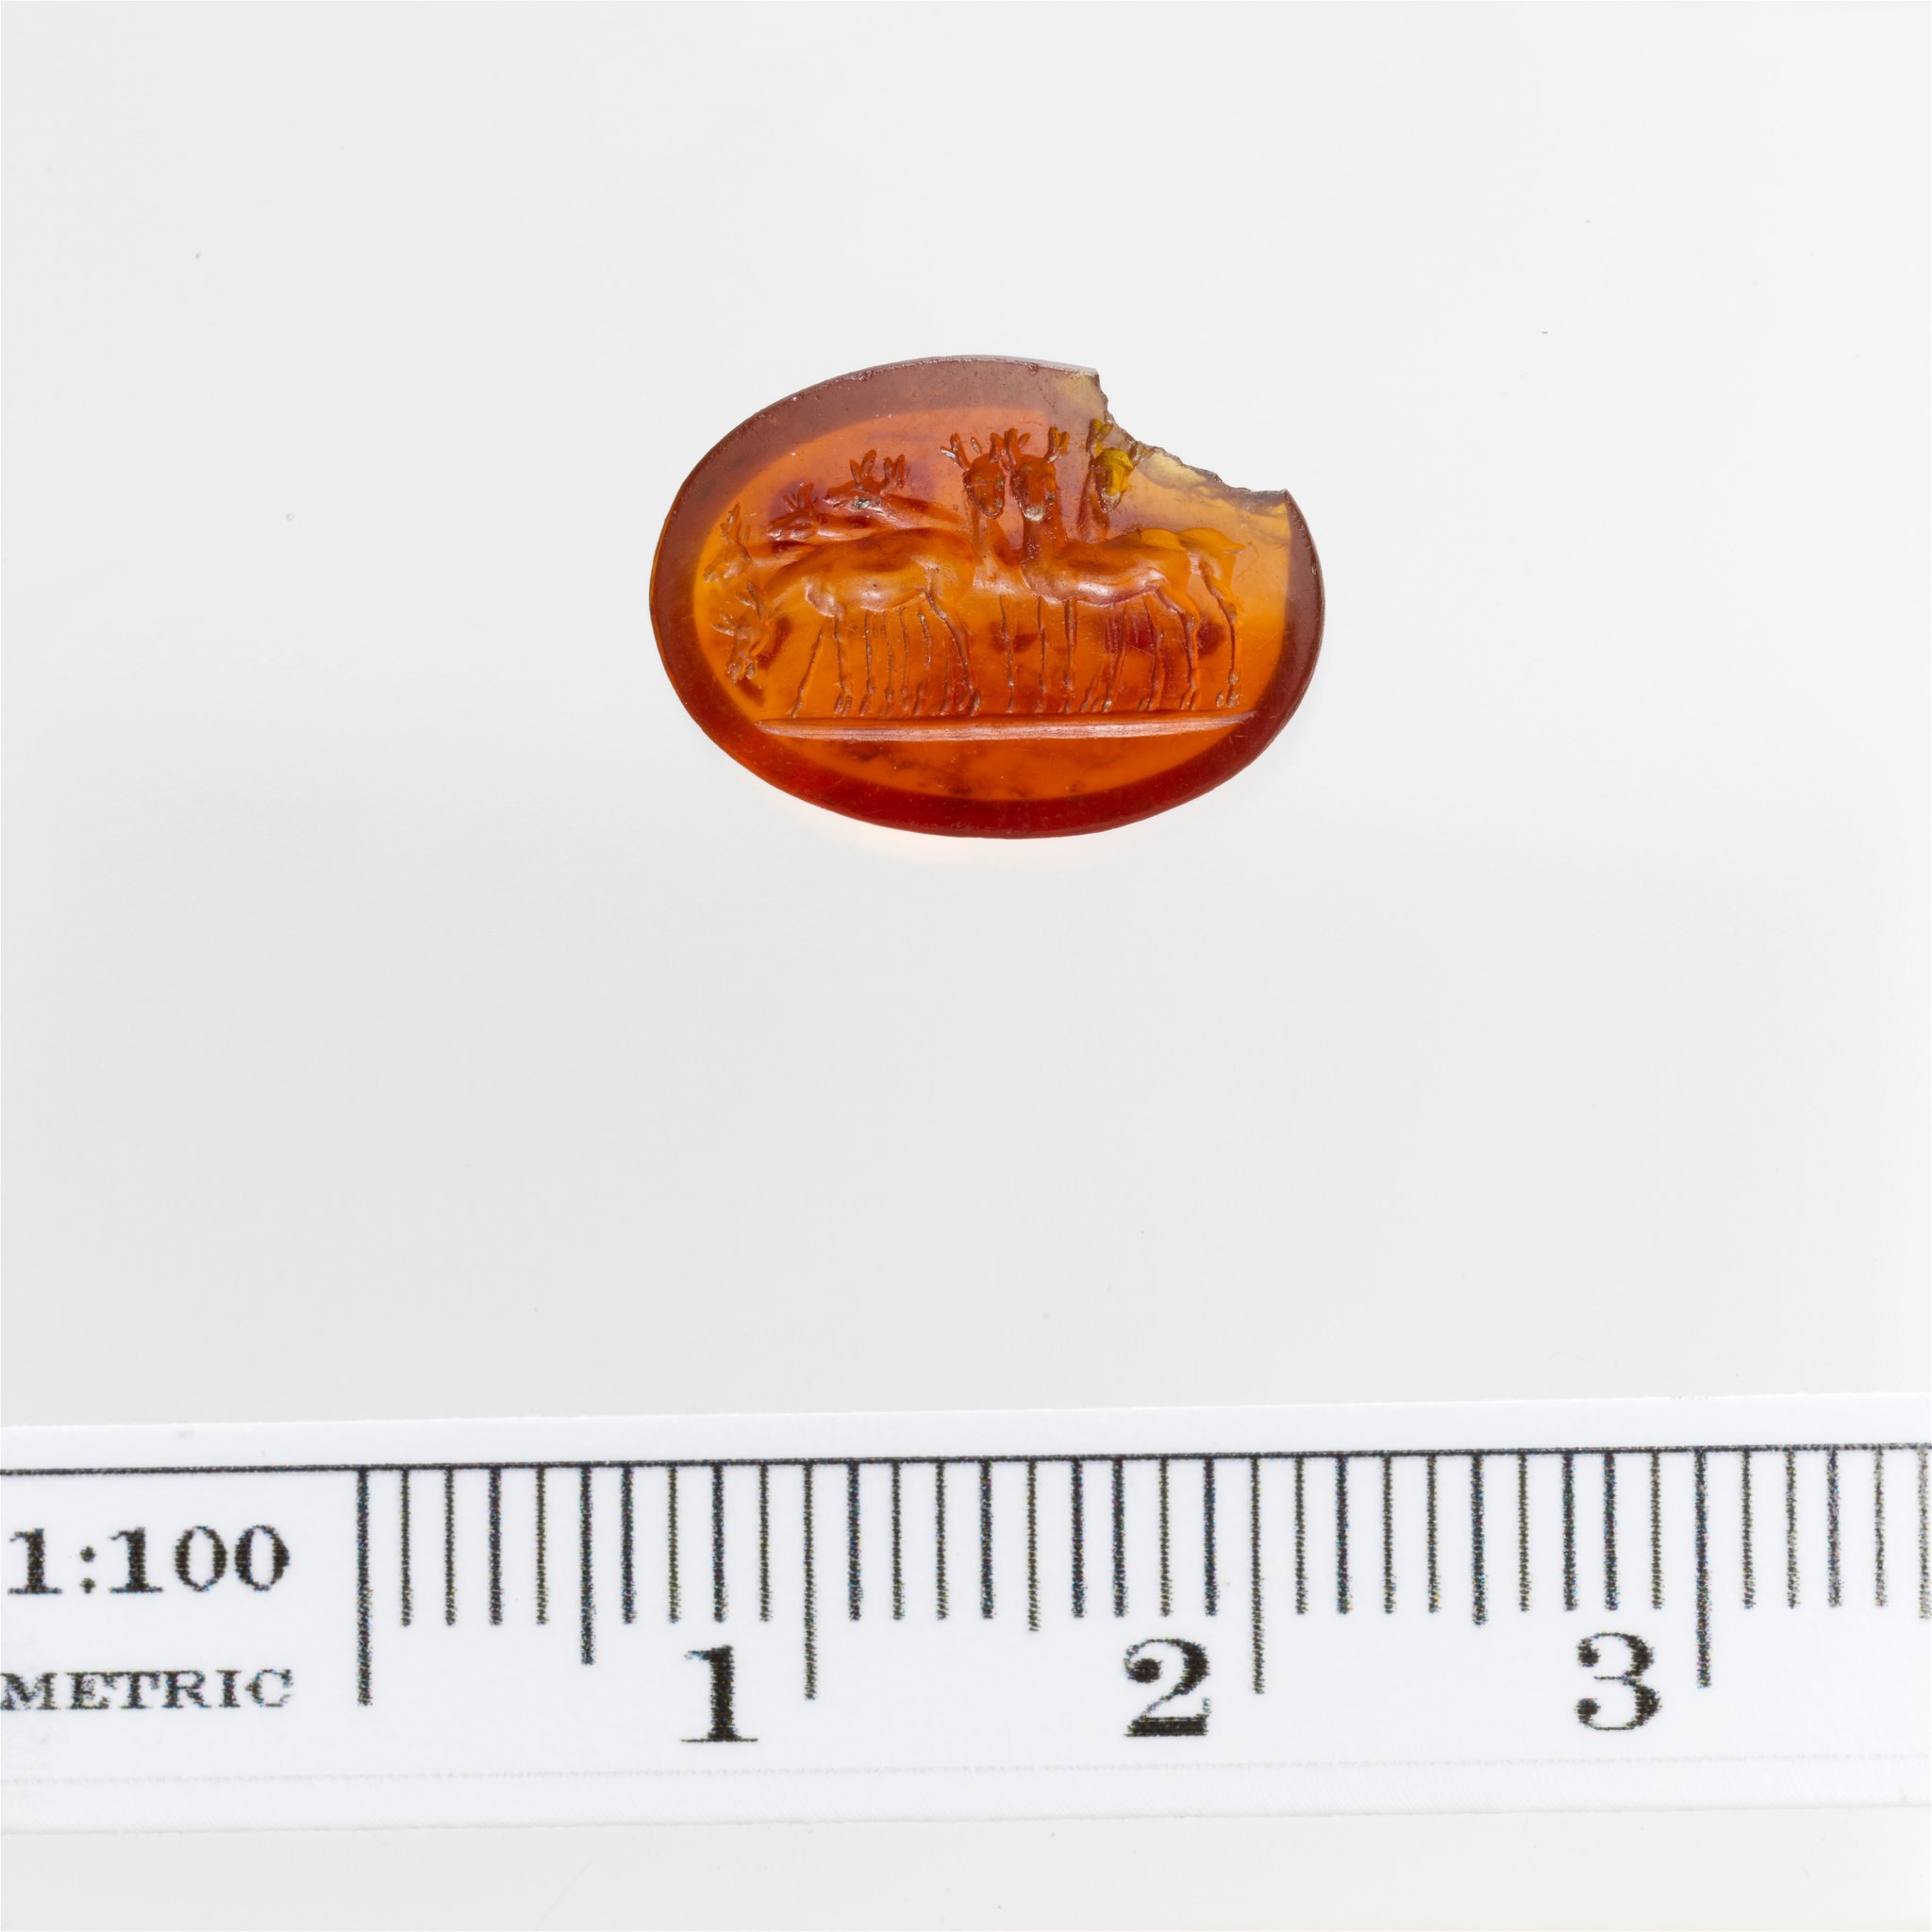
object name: intaglio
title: Sard ring stone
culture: roman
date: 101-200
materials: gemstone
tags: deer